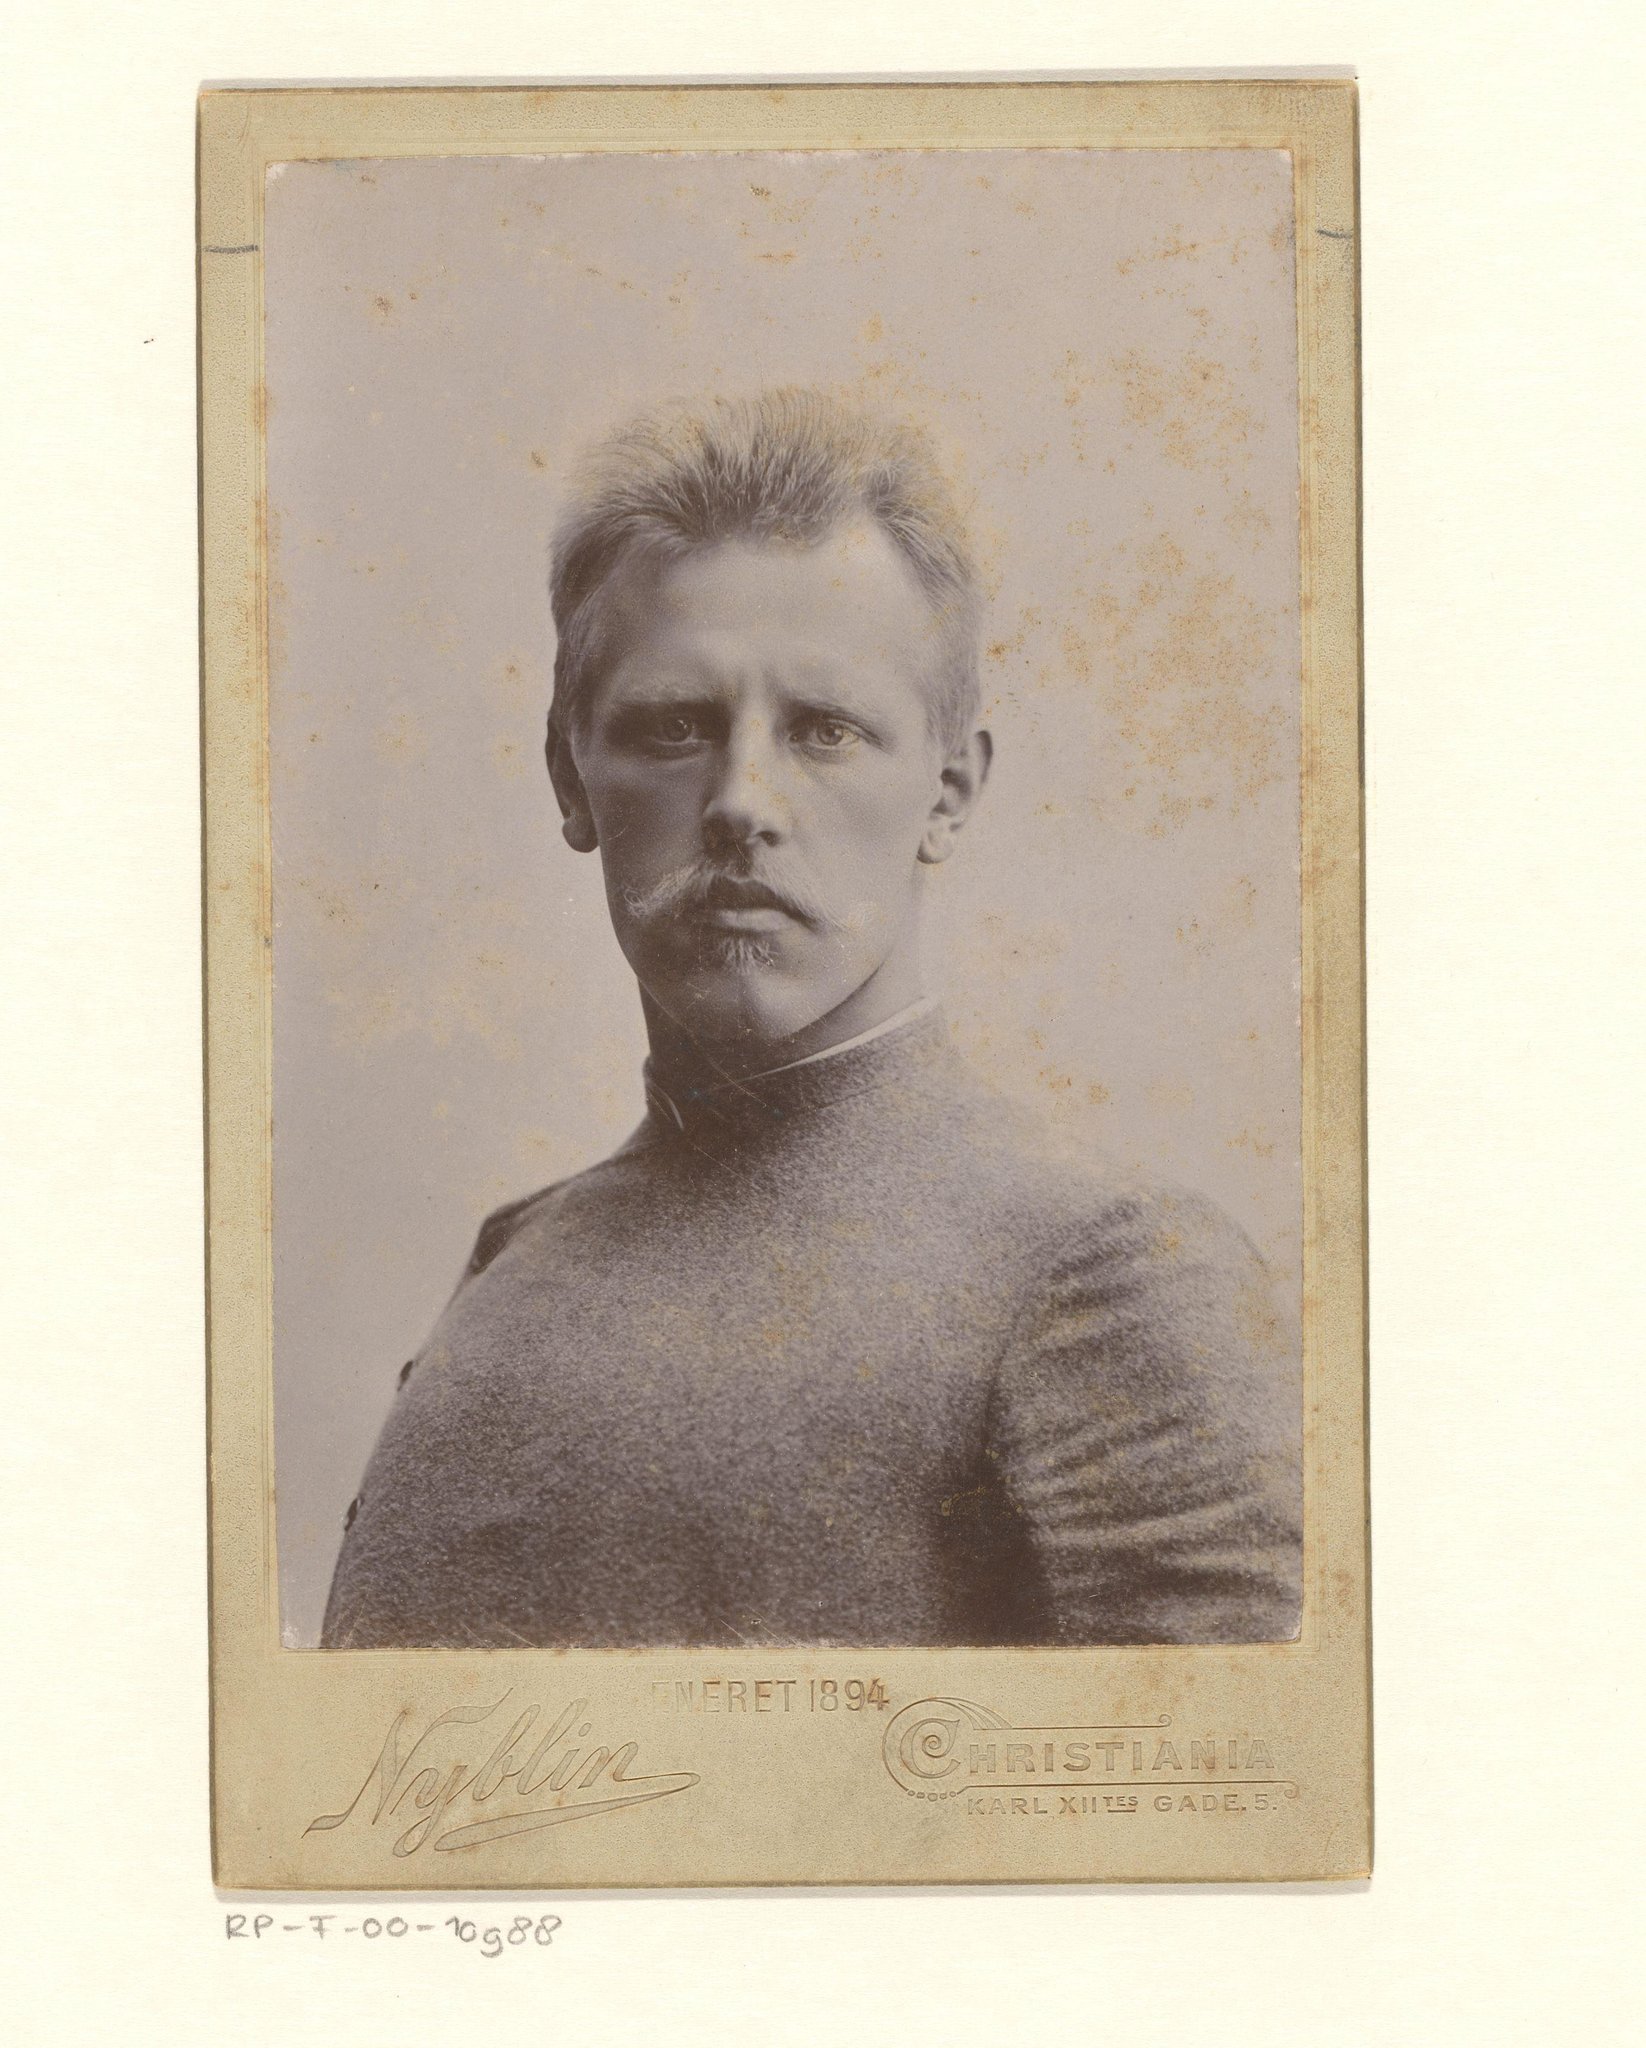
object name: cabinet photograph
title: Portret van Fridtjof Nansen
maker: daniel nyblin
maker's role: fotograaf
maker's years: 1856-1923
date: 1894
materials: cardboard, photographic support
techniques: collodion silver print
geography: christiania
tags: historical persons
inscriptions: collector's mark: Lugt 2228a, :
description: Een eigenhandige beschrijving van de poolreis van Nansen werd uitgegeven door Uitgeversmaatschappij L.J. Veen. Zie Nansen, Fridtjof. Poolreis (naar The Daily Chronicle van 2, 3 en 4 november 1896). Amsterdam: Veen, c. 1896.